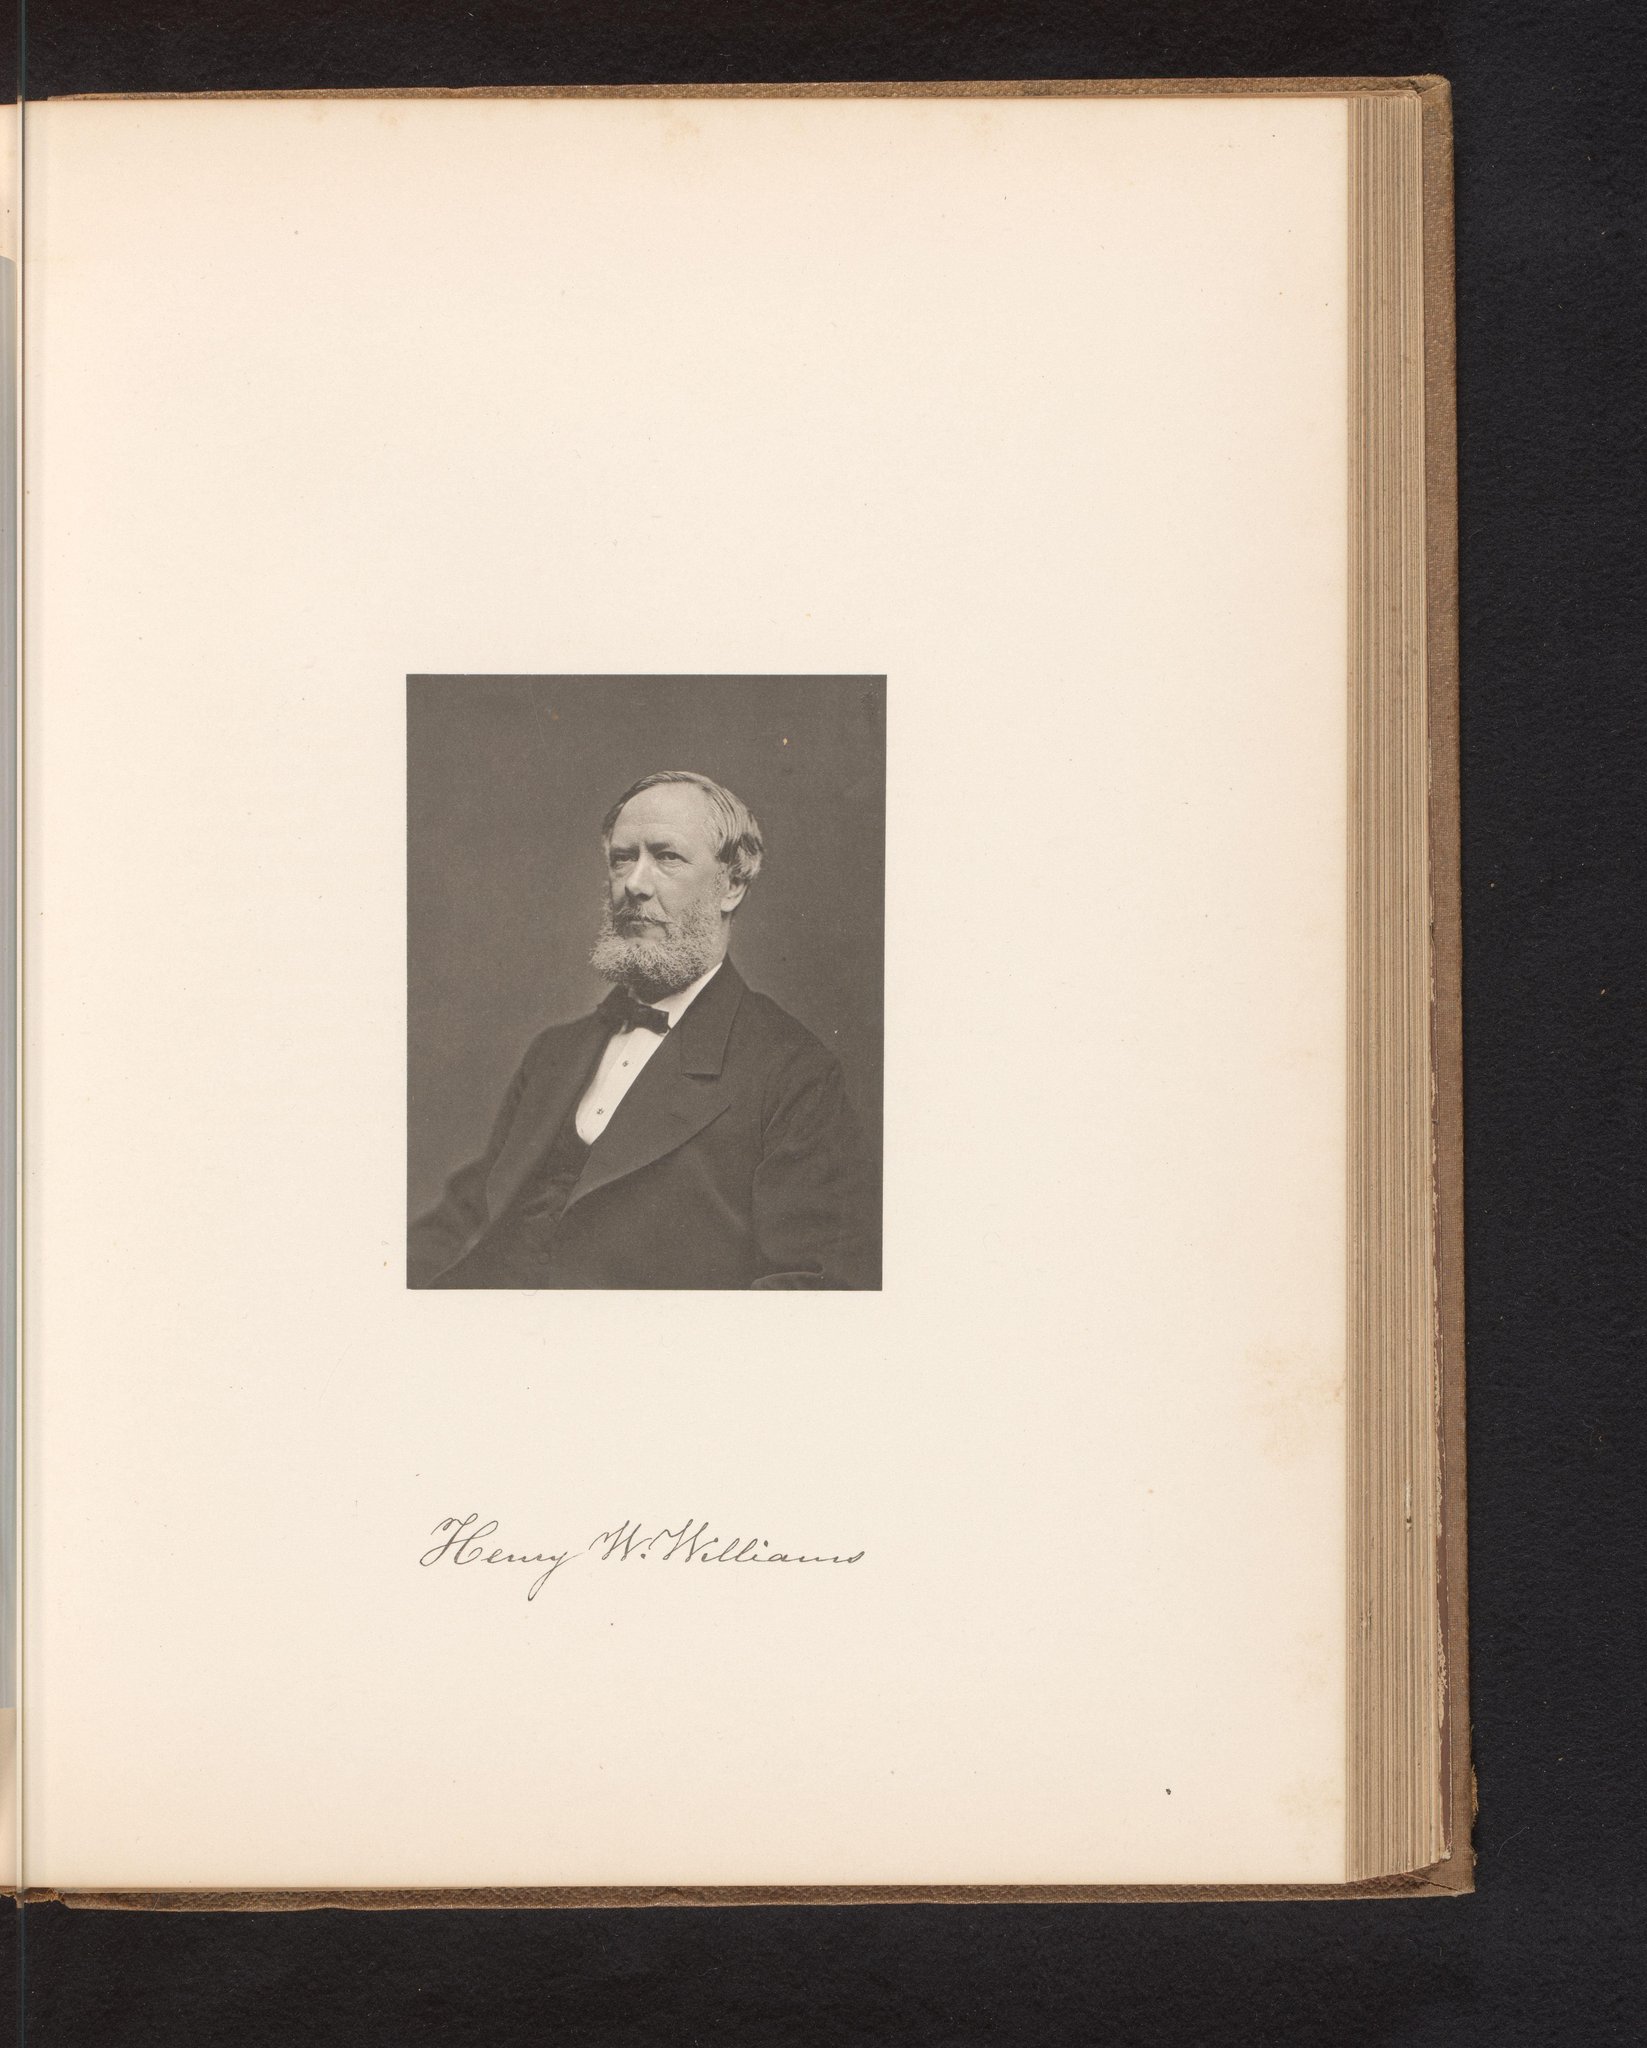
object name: page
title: Henry W. Williams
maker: Anonymous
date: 1870-1875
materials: paper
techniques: photograph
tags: historical persons, physician, doctor, professor